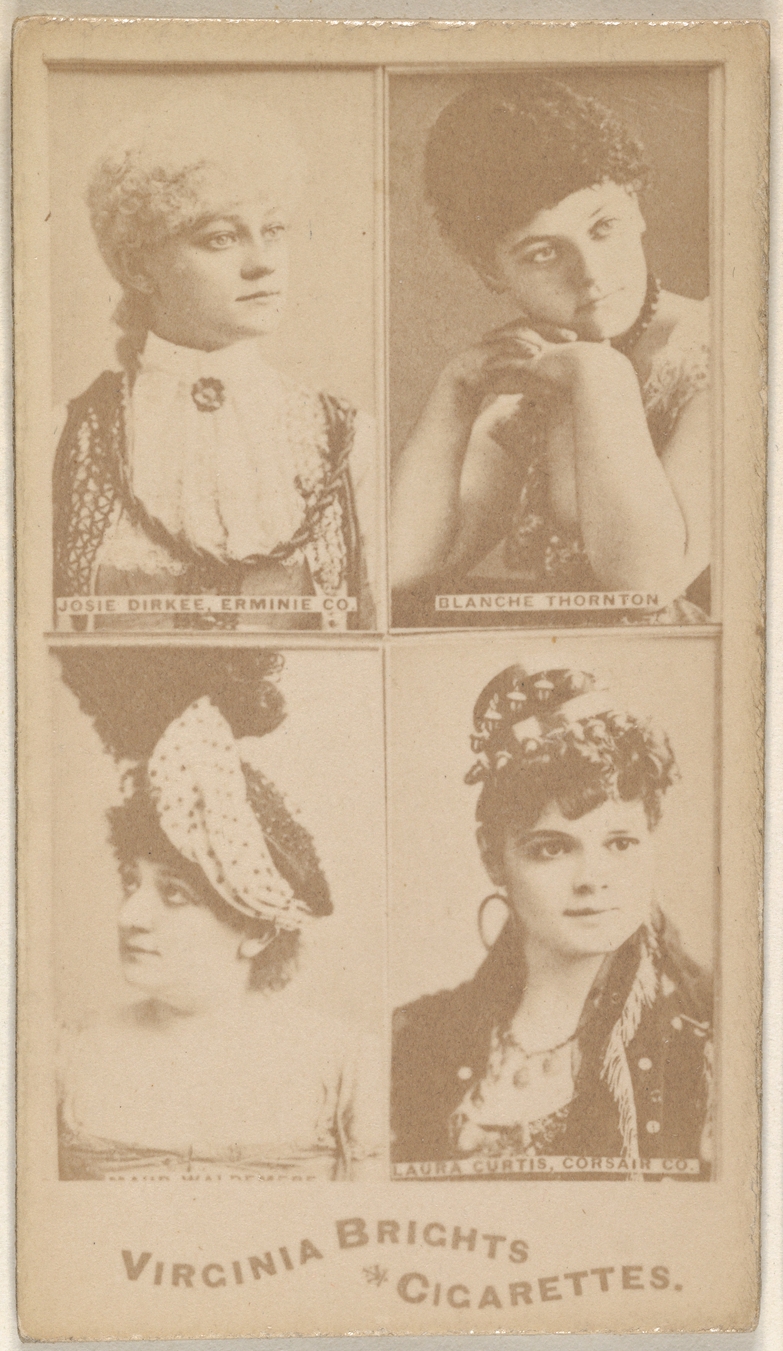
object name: photograph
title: Josie Dirkee, Erminie Co./ Blanche Thornton/ Laura Curtis, Corsair Co., from the Actors and Actresses series (N45, Type 4) for Virginia Brights Cigarettes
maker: allen & ginter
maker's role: publisher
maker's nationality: american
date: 1888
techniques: albumen silver print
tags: portraits,women